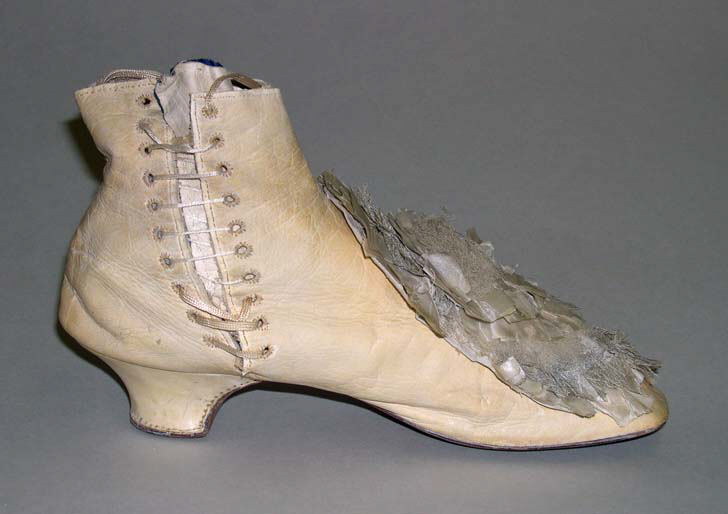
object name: shoe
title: Shoes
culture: italian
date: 1860-1879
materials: leather